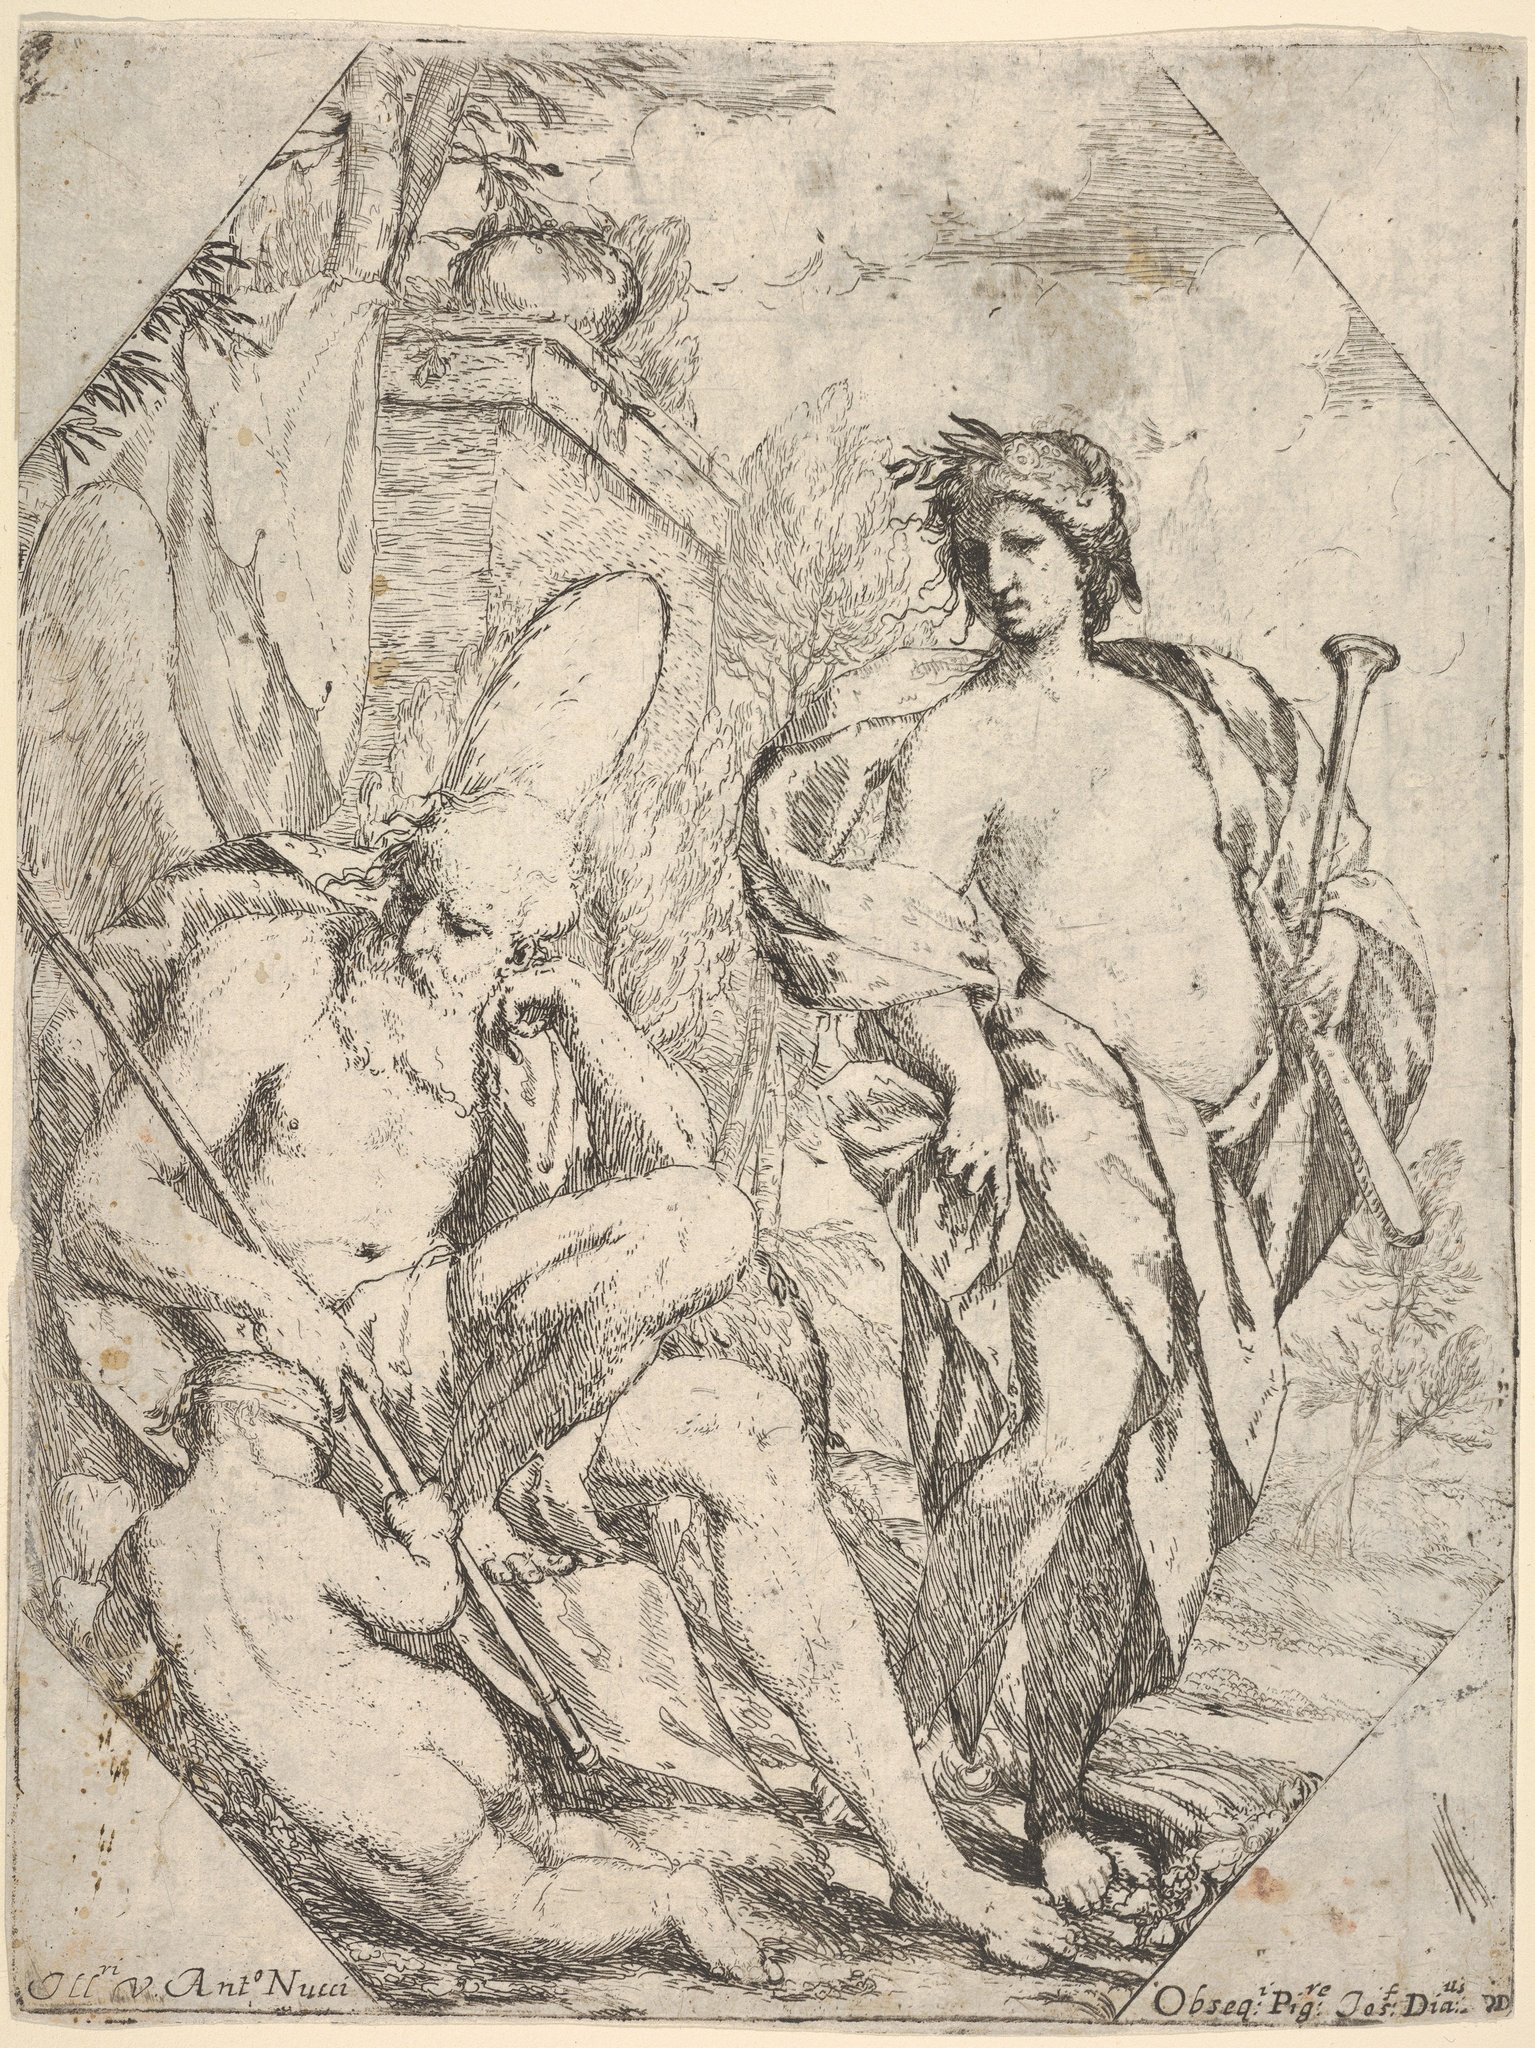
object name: print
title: Saturn, Eros, and a Woman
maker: giuseppe diamantini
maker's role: artist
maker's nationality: italian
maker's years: 1621-1705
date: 1650-1700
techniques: etching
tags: women,eros,saturn